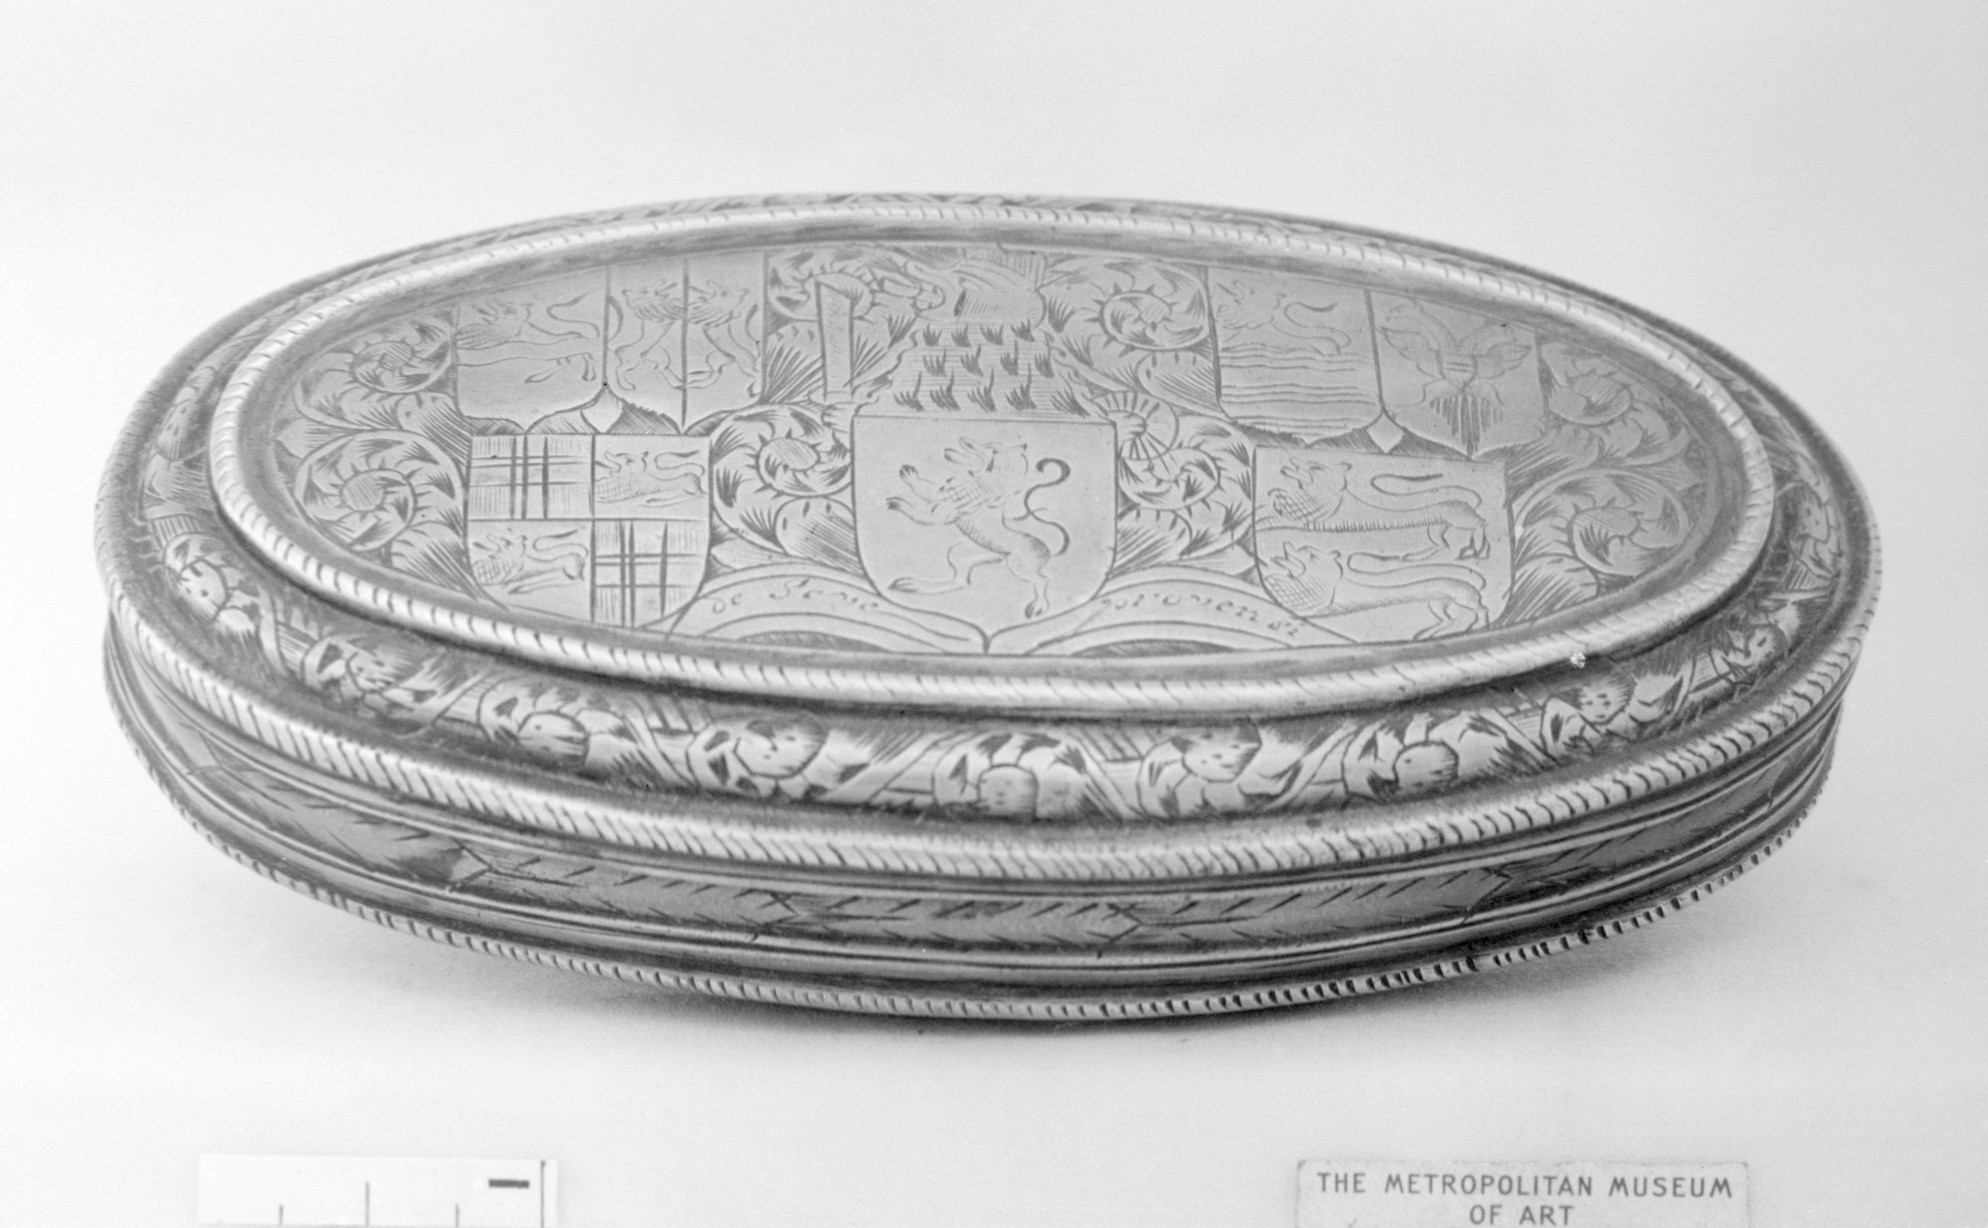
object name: tobacco box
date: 1667-1733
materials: brass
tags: lions,coat of arms